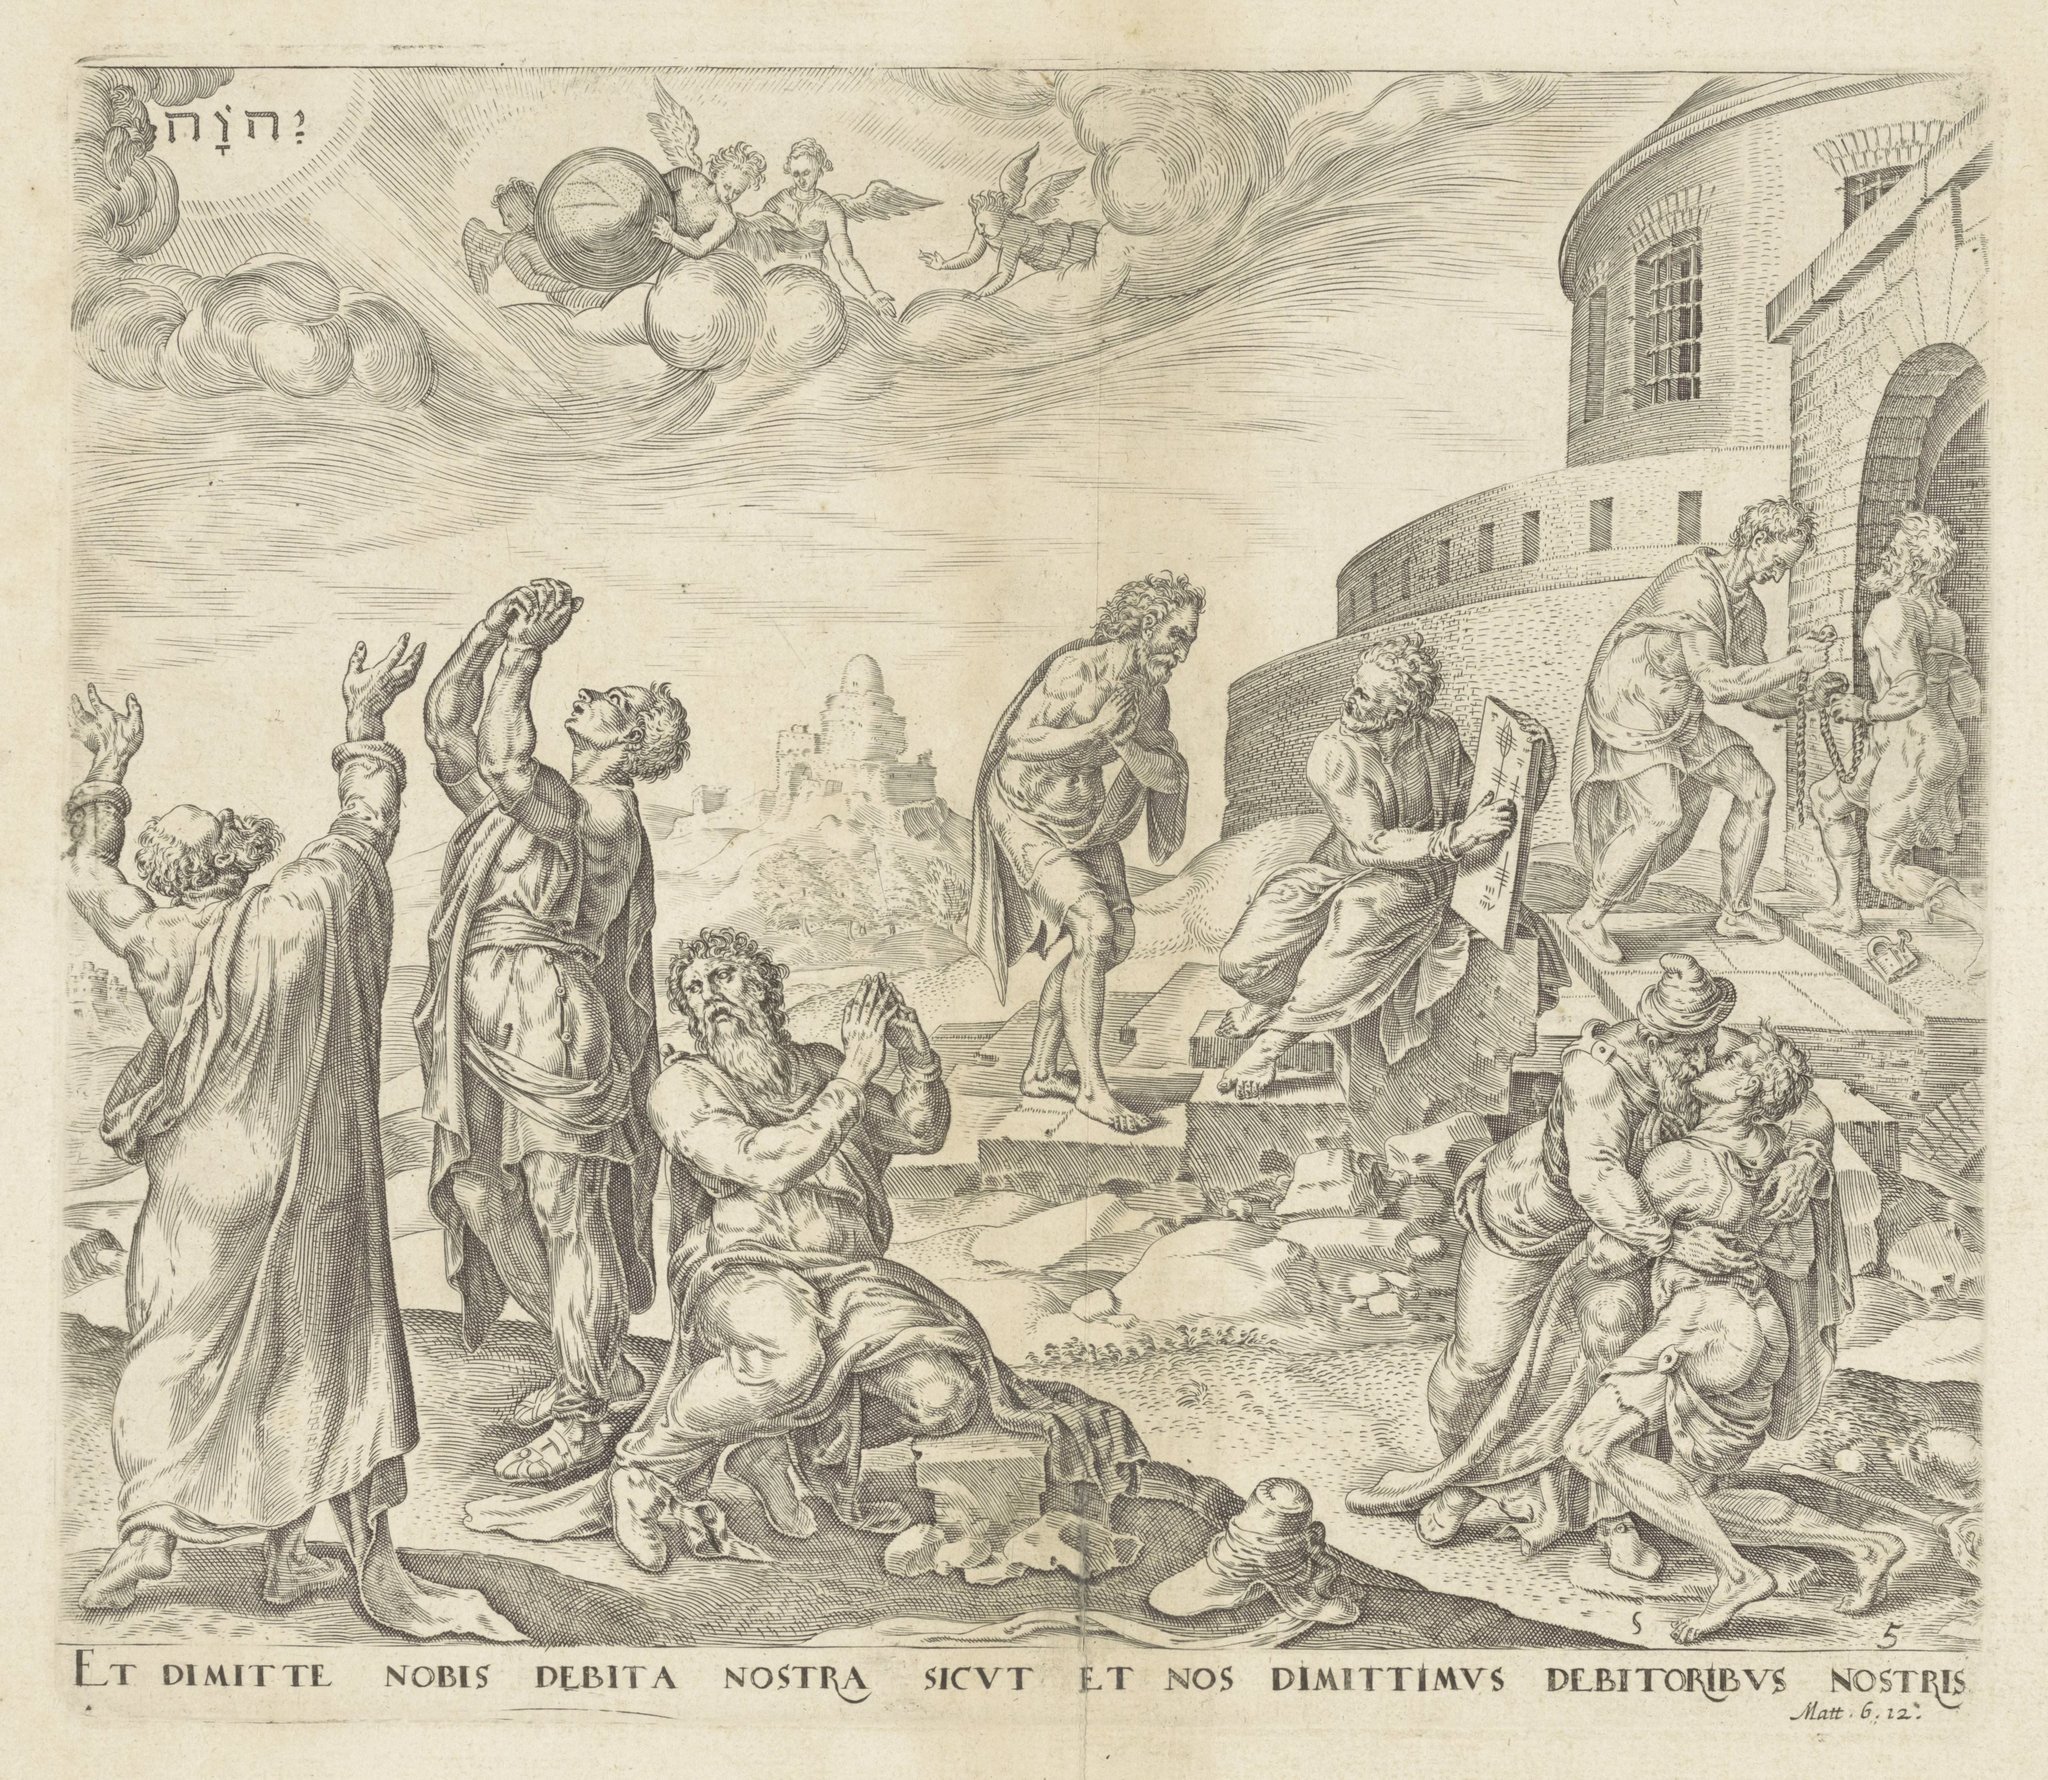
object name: print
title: Onze Vader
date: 1569-1573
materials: paper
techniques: engraving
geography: amsterdam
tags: tetragram (in roman or hebrew script) ~ symbol of god the father, 'and forgive us our debts, as we also have forgiven our debtors' ~ the lord's prayer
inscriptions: collector's mark: Lugt 2228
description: Illustratie van een regel van het Onze Vader gebed: Vergeef ons onze schulden, zoals ook wij hebben vergeven wie ons iets schuldig was. Mannen vragen vergiffenis aan God de Vader. Ze bidden richting de hemel, waar het tetragram als symbool van God de Vader verschijnt. Ze vergeven tevens elkaar. Een man wordt uit de gevangenis bevrijd. Rechts op de voorgrond omarmt de vader de verloren zoon. Onder de voorstelling dit gedeelte van het Onze Vader in het Latijn en een verwijzing naar de Bijbeltekst in Mat. 6:12.